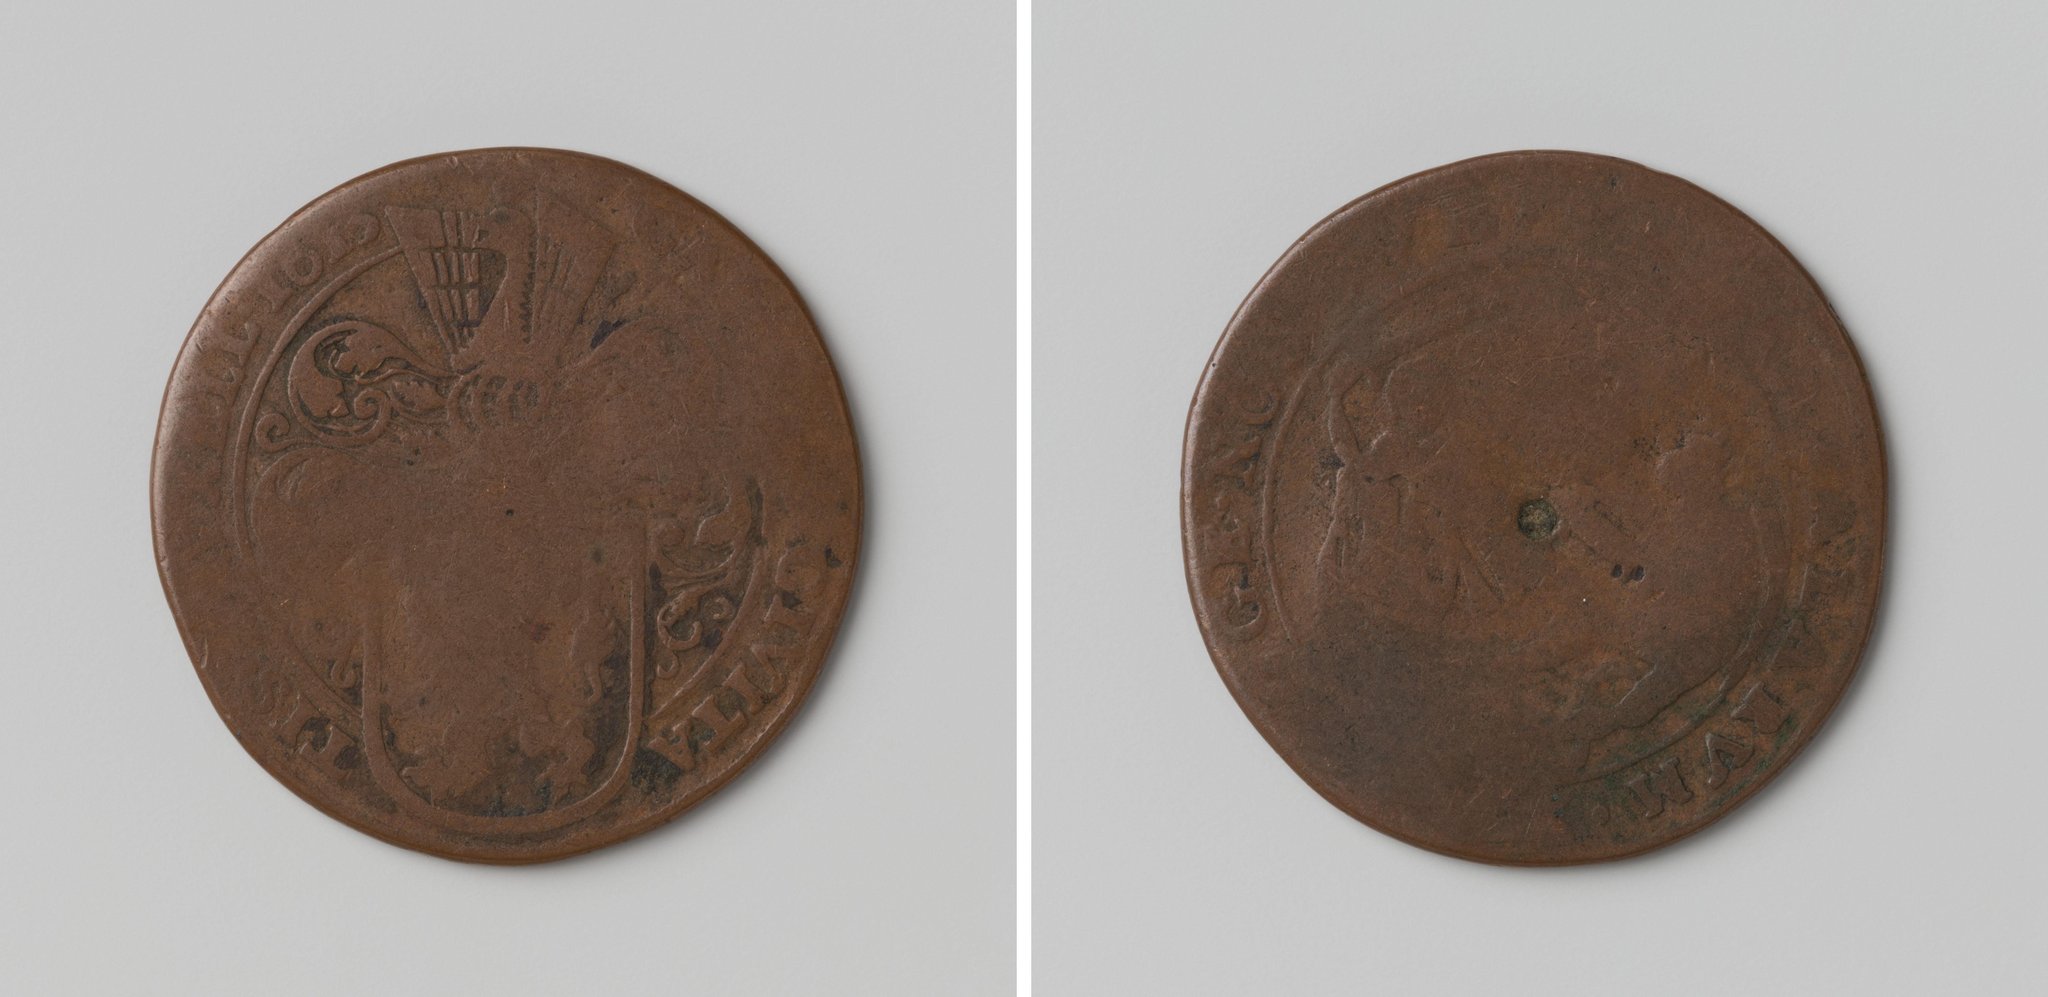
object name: jeton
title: Stad Brussel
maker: Anonymous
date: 1613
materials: copper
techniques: striking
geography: antwerp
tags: brussels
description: Koperen penning. Voorzijde: gehelmd wapenschild binnen omschrift. Keerzijde: aartsengel Michael met zwaard boven hoofd geheven in gevecht met ter aarde liggende draak binnen omschrift